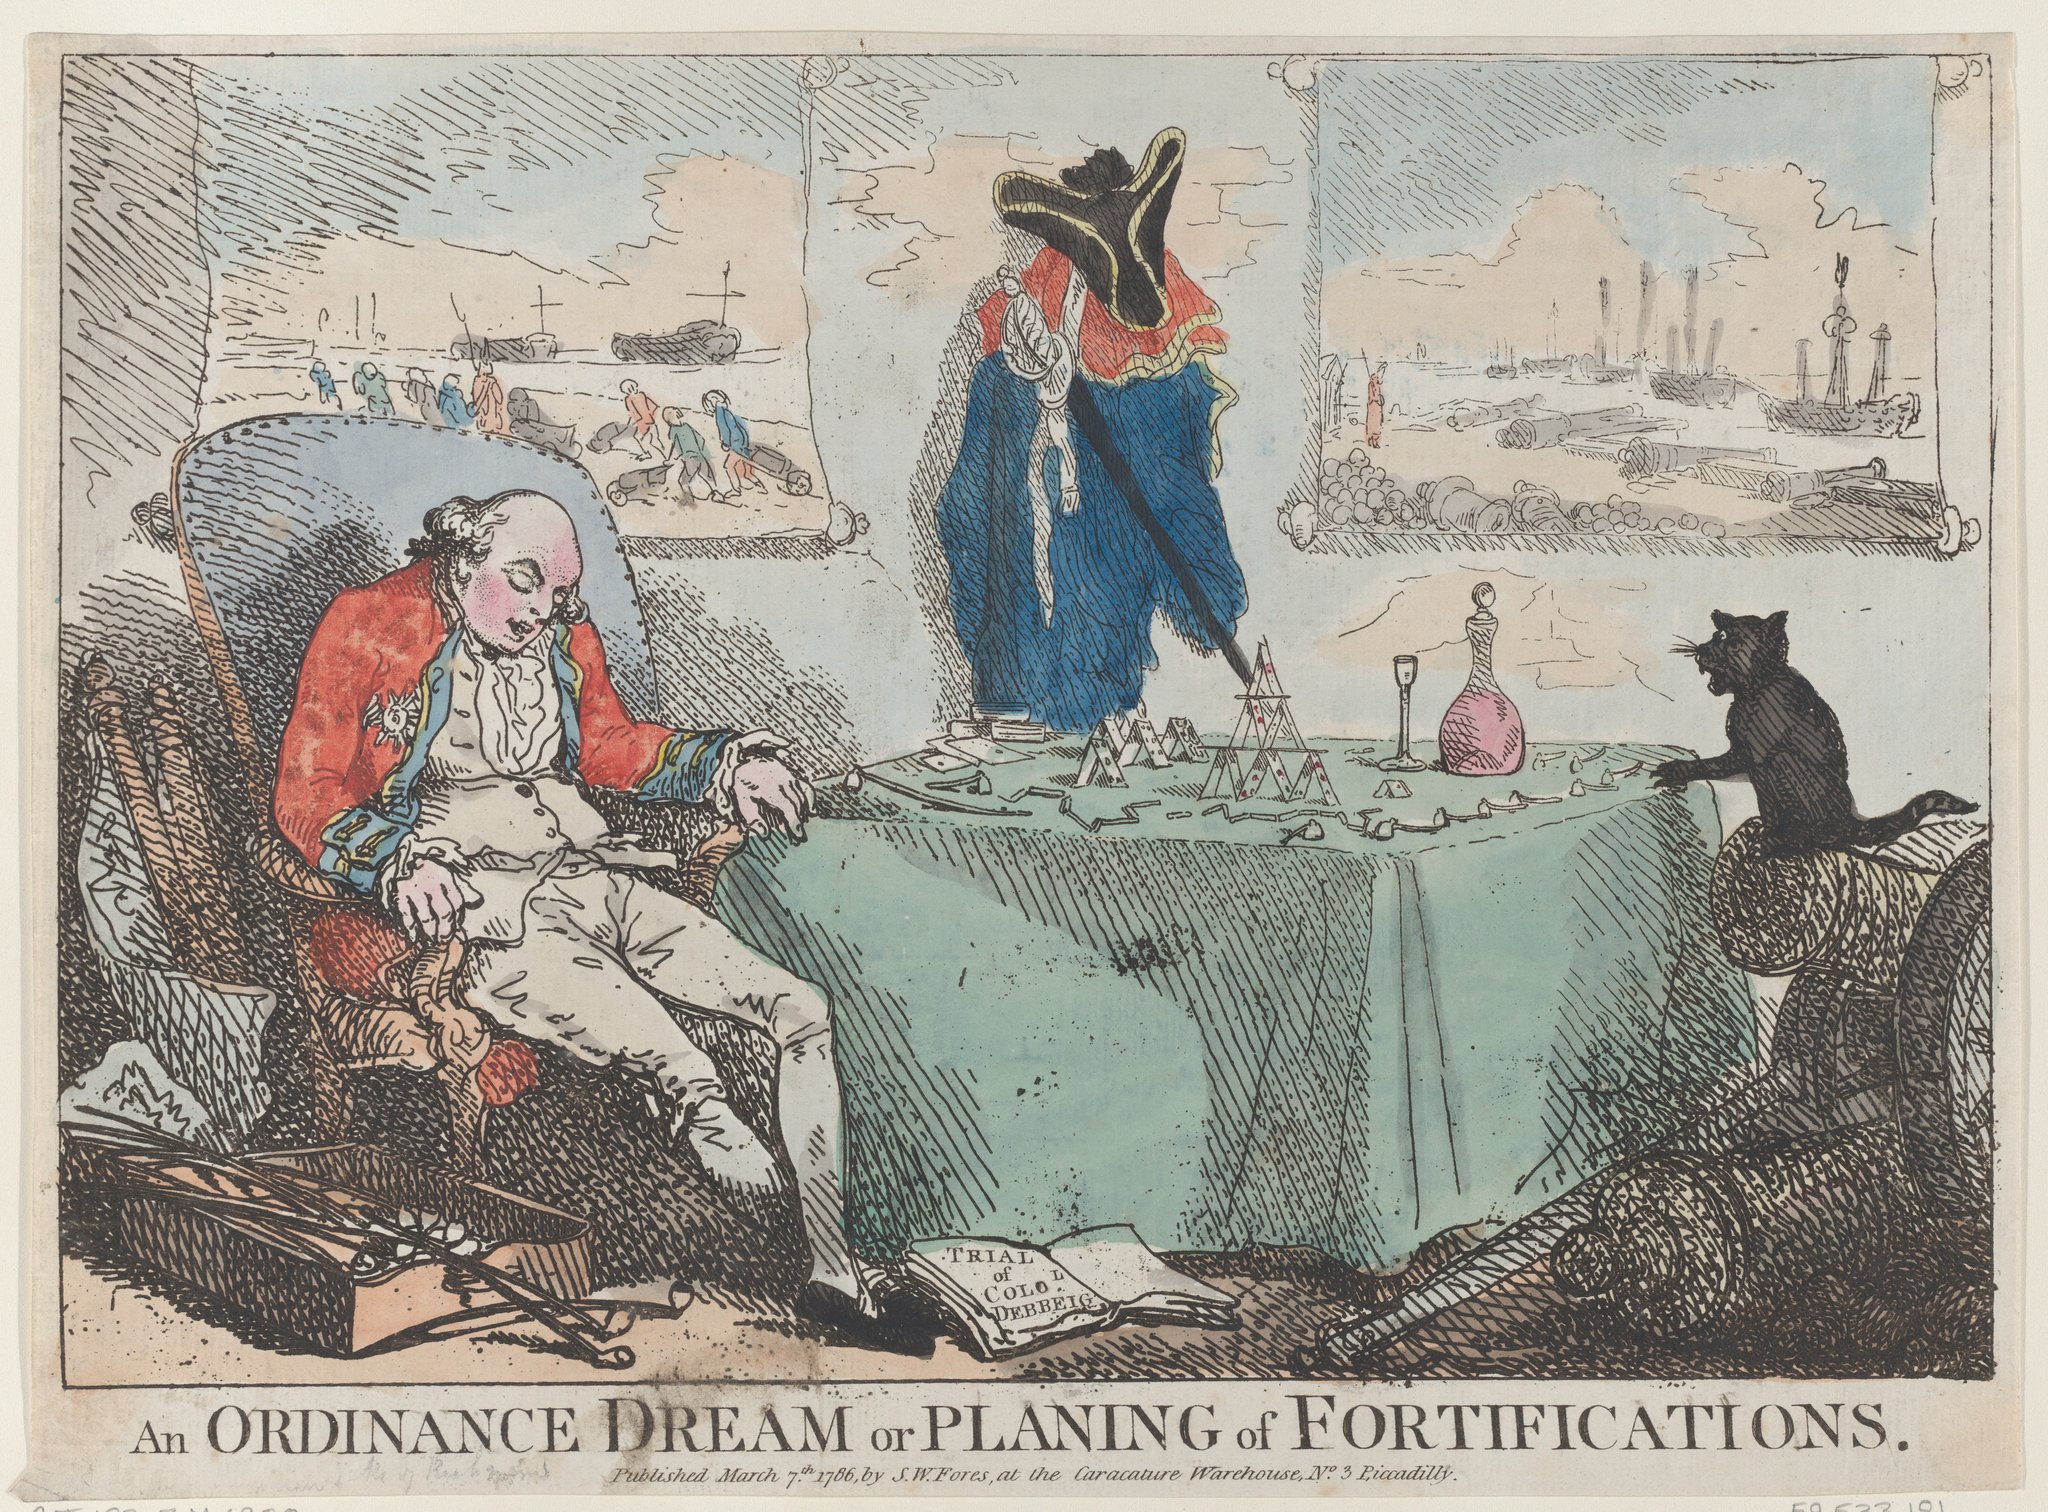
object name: print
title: An Ordinance Dream or Planning of Fortifications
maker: thomas rowlandson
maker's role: artist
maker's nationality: british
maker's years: 1757-1827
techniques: etching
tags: satire,sleeping,men,playing cards,cats